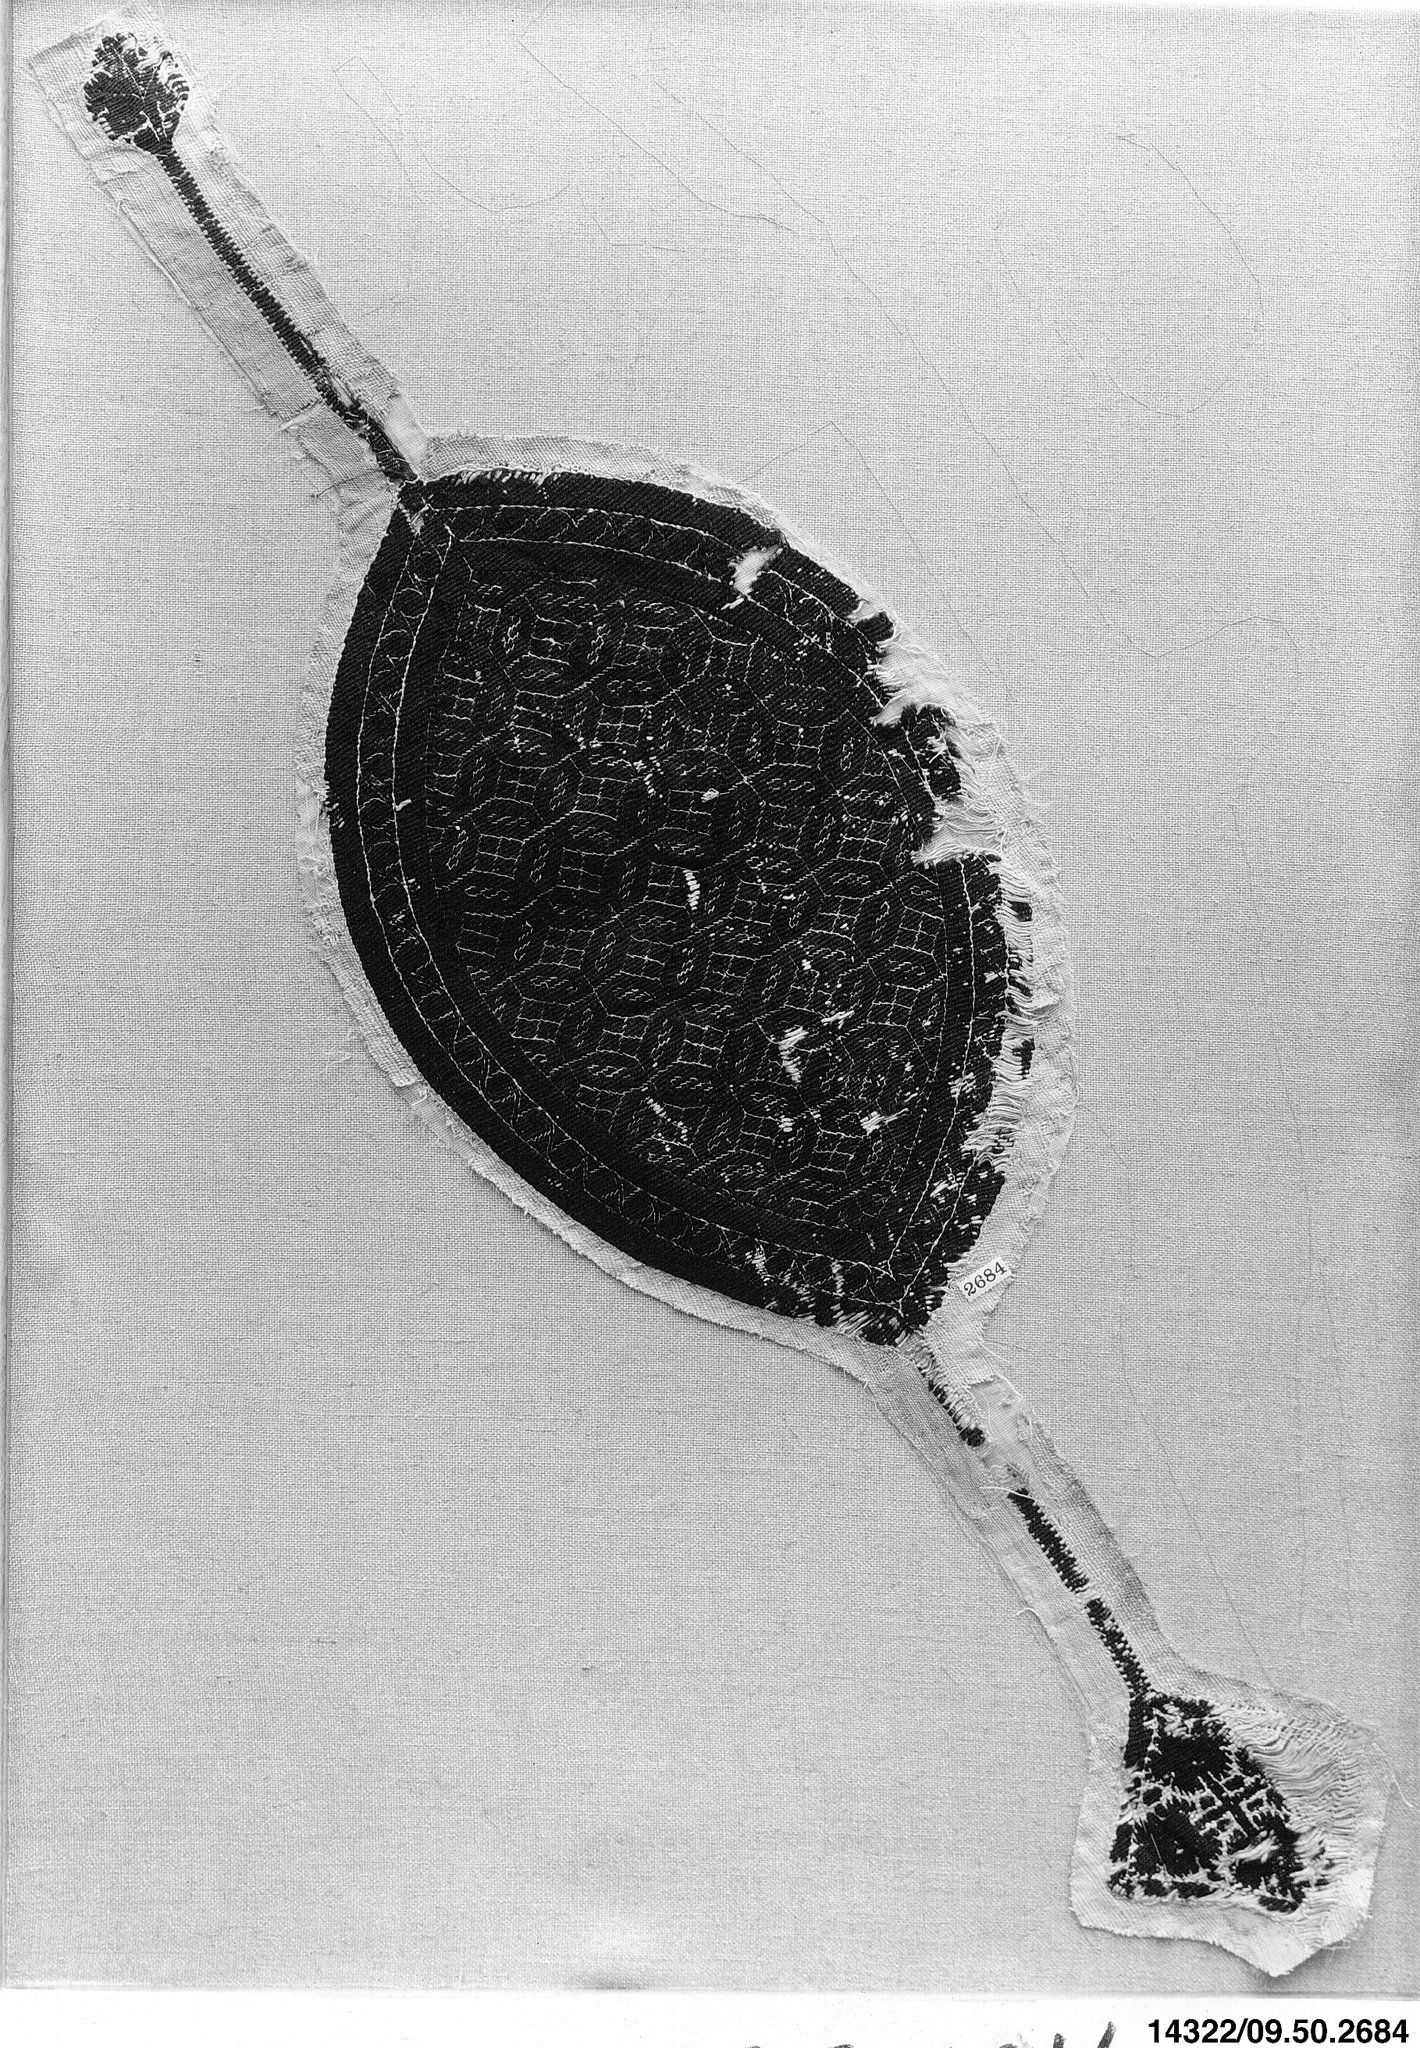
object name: panel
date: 201-400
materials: linen, wool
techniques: weave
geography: egypt